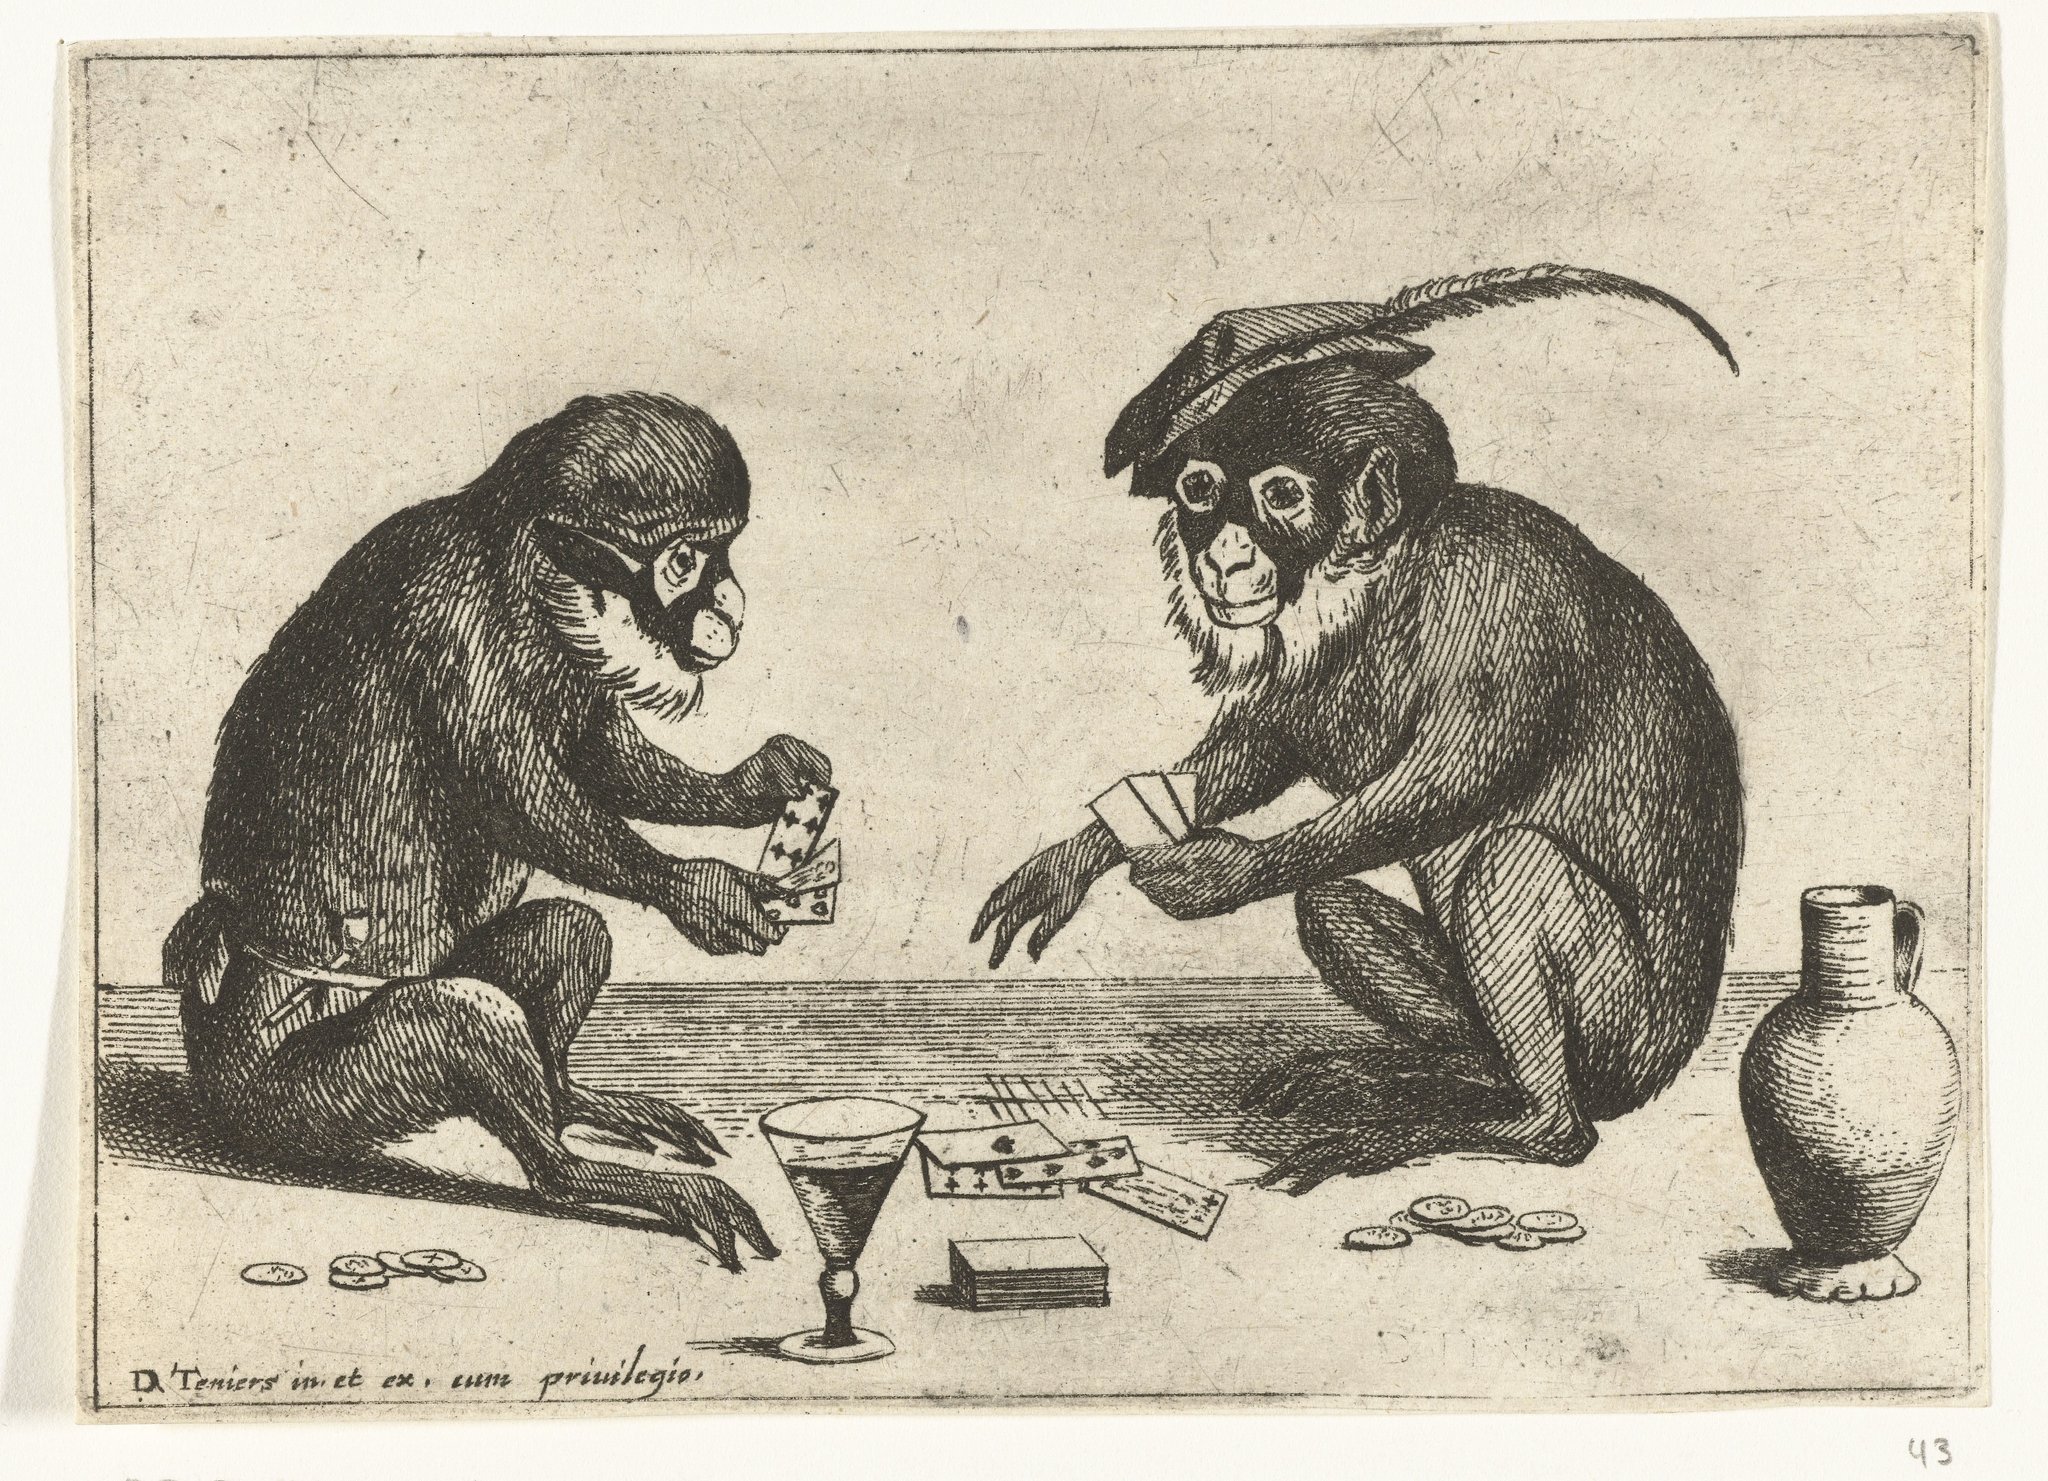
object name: print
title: Twee apen kaarten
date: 1635-1690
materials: paper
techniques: etching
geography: southern netherlands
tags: animals acting as human beings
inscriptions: collector's mark: Lugt 2228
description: Twee apen zitten op de grond en zijn aan het kaarten. De rechtse draagt een hoed met een hanenveer. Prent uit een serie van zes prenten en een titelprent waarin verschillende menselijke bezigheden door apen voorgesteld worden.